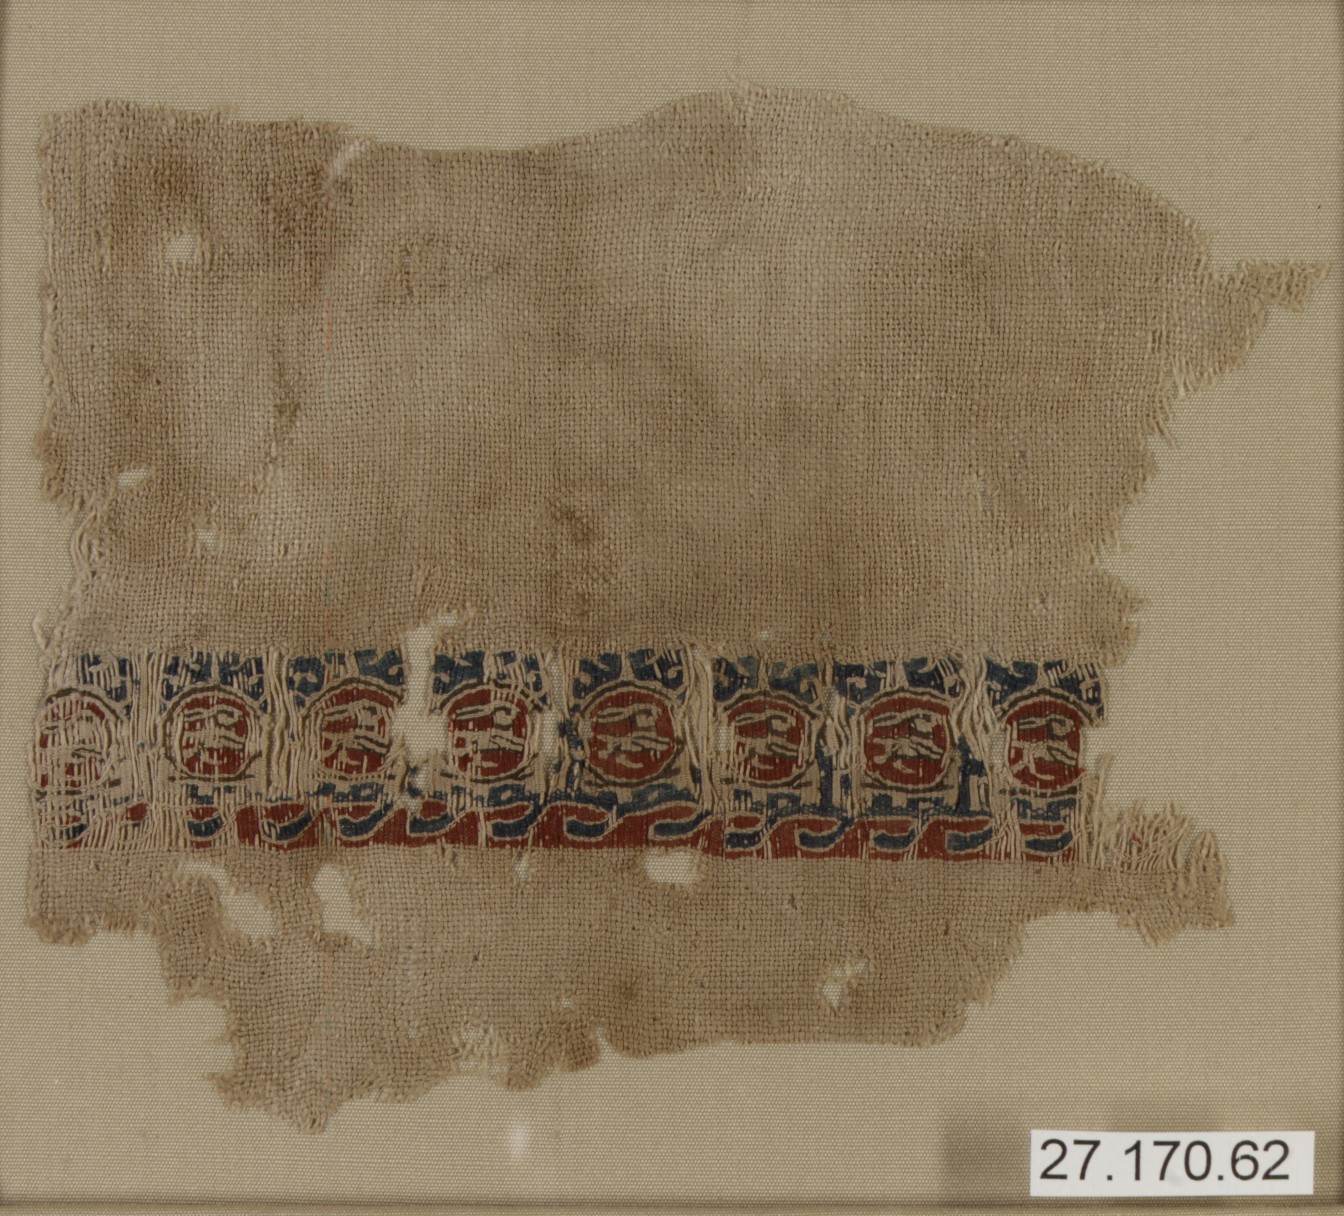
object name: textile fragment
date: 1001-1100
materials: linen, silk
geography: egypt